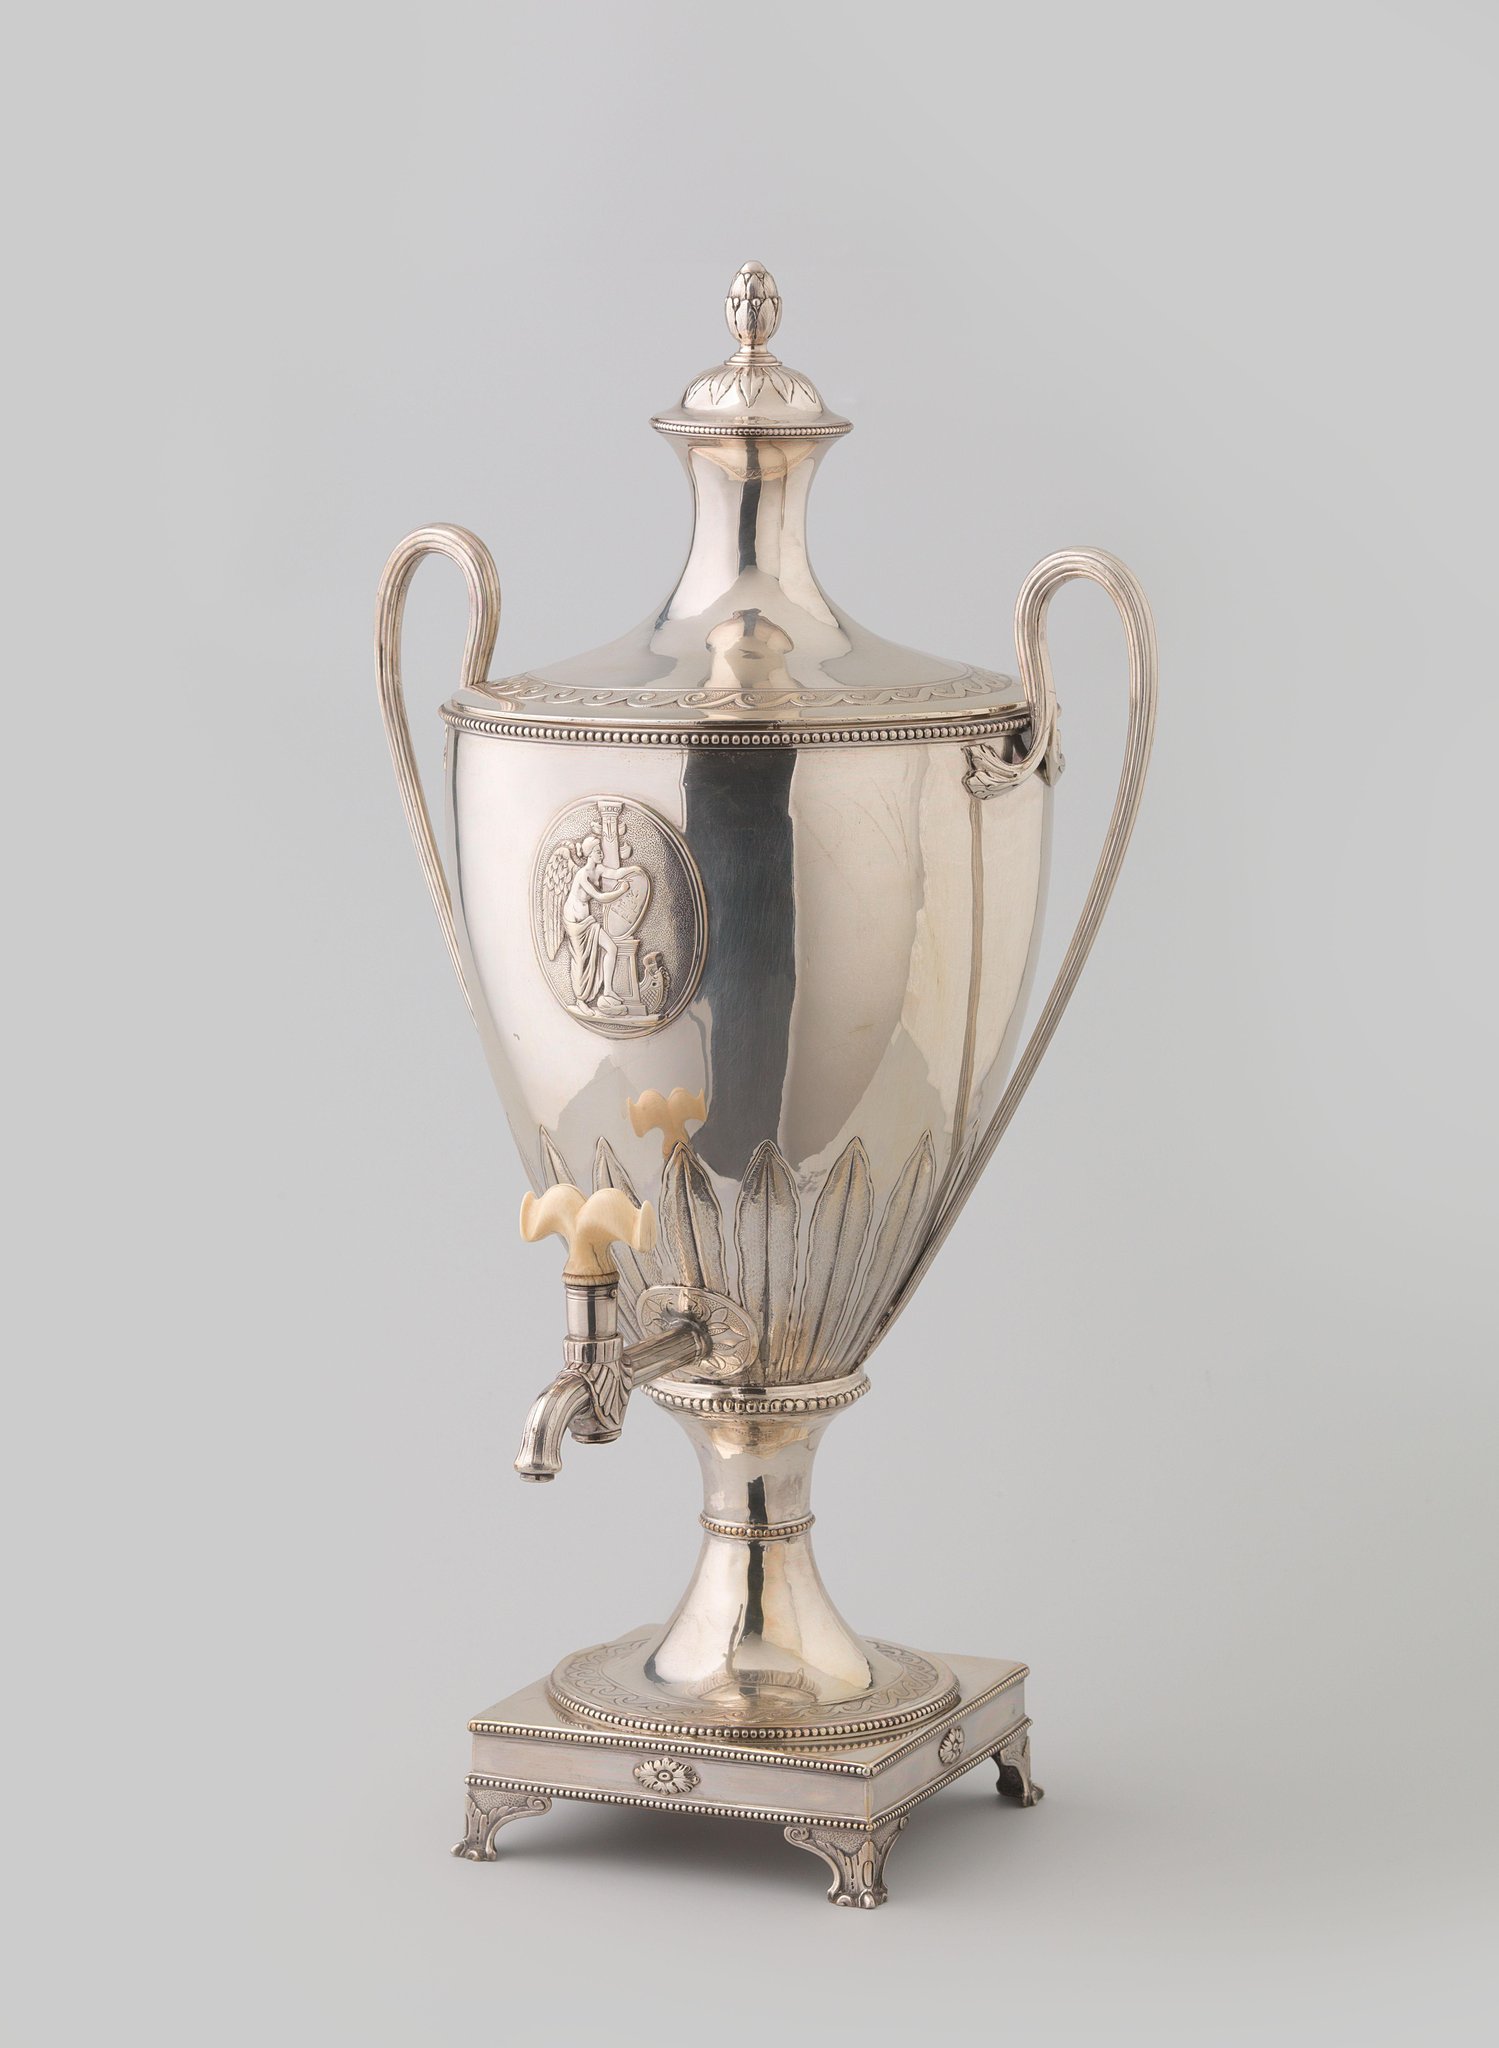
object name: coffee urn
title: Kraantjeskan met handvat van ivoor, met deksel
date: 1780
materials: ivory, silver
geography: london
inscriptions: mark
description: Tea urn. Silver, the handle of ivory. London, 1780, by Andrew Fogelberg and Stephen Gilbert.